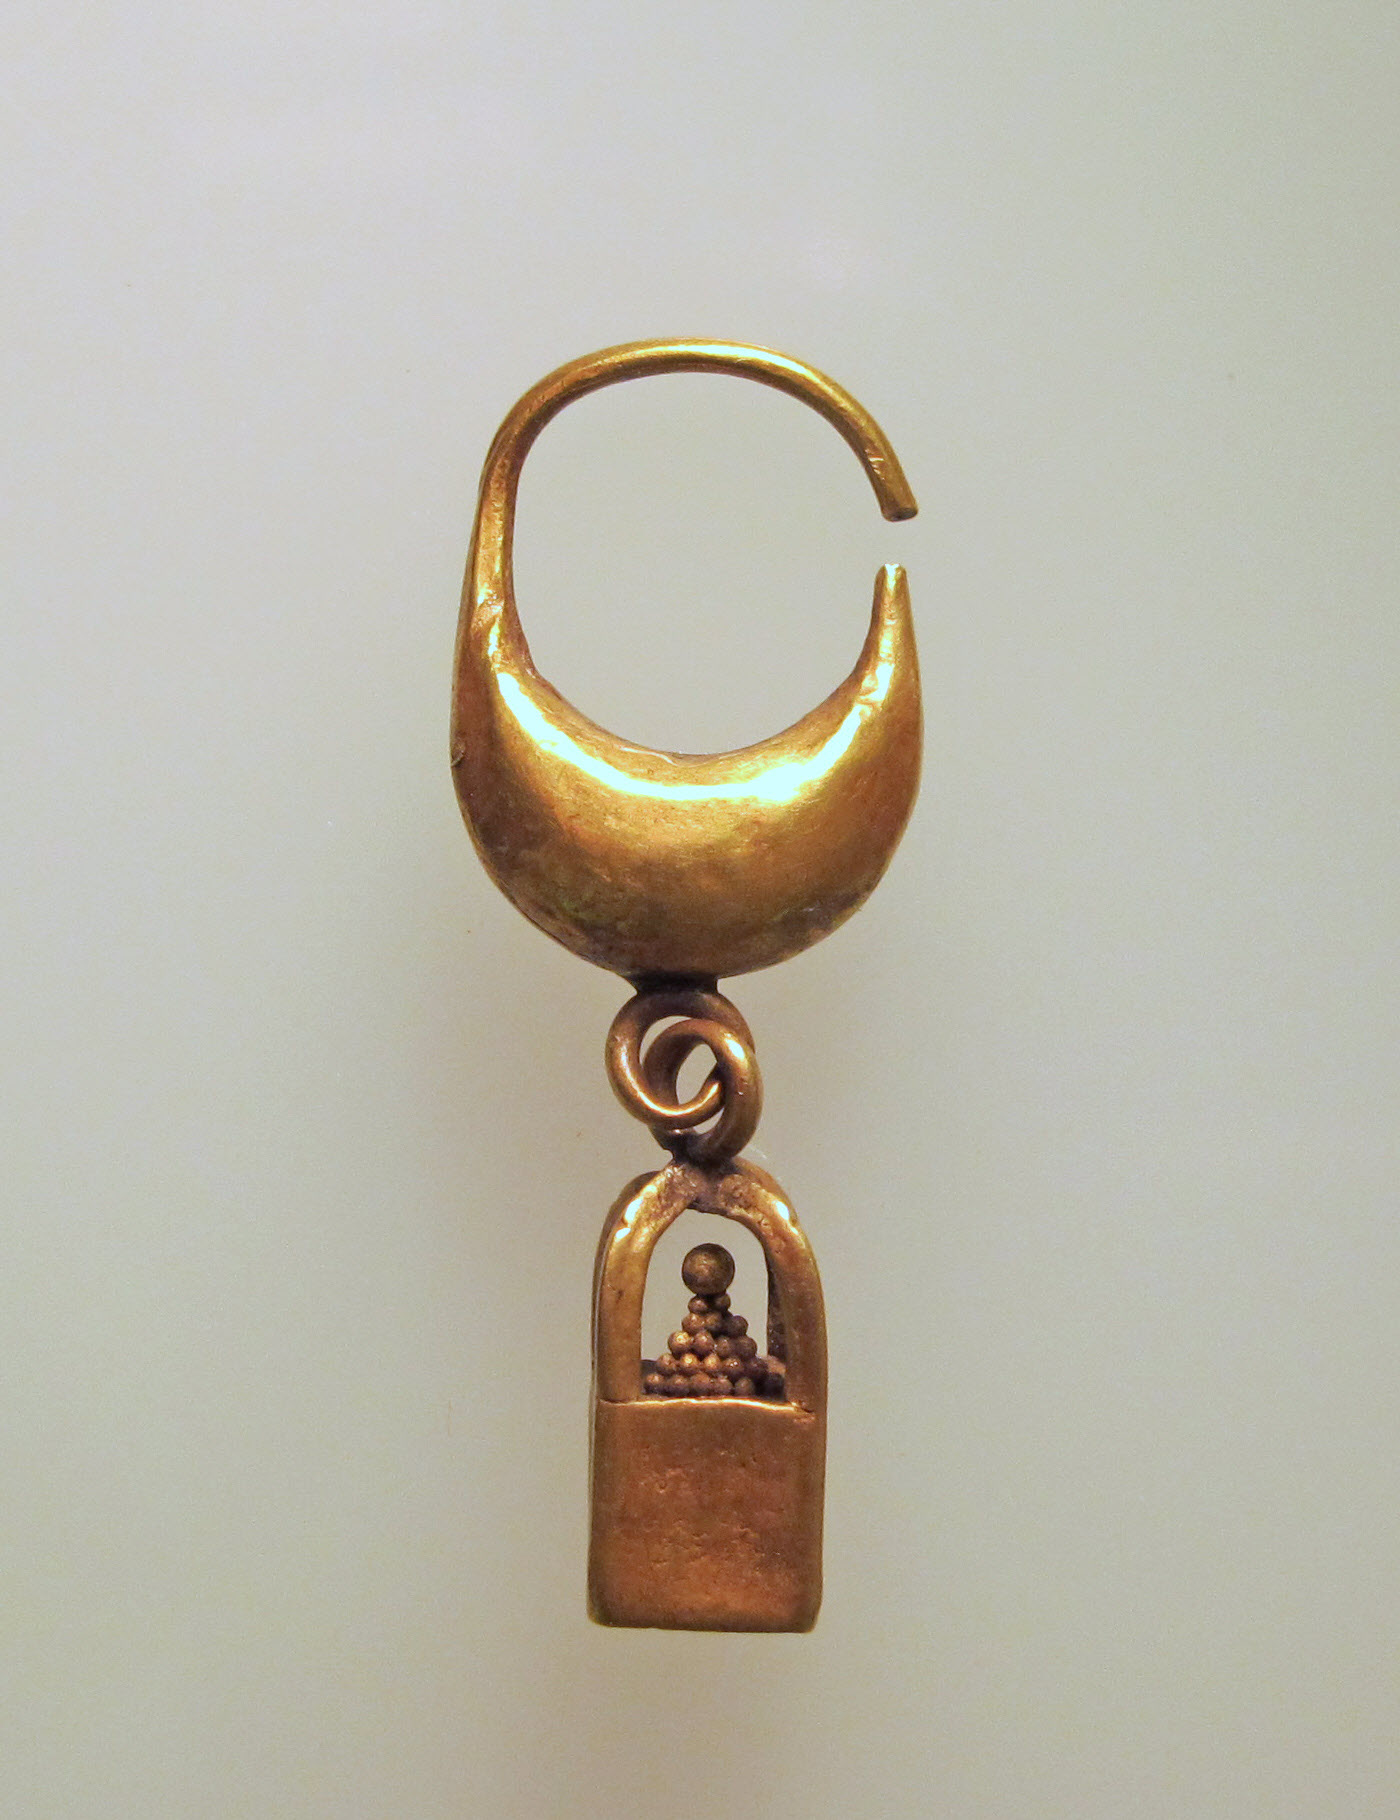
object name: earring, boat shaped with cage and ball pendant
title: Earring, boat-shaped with cage and ball pendant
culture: cypriot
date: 3900 BCE-100 CE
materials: gold